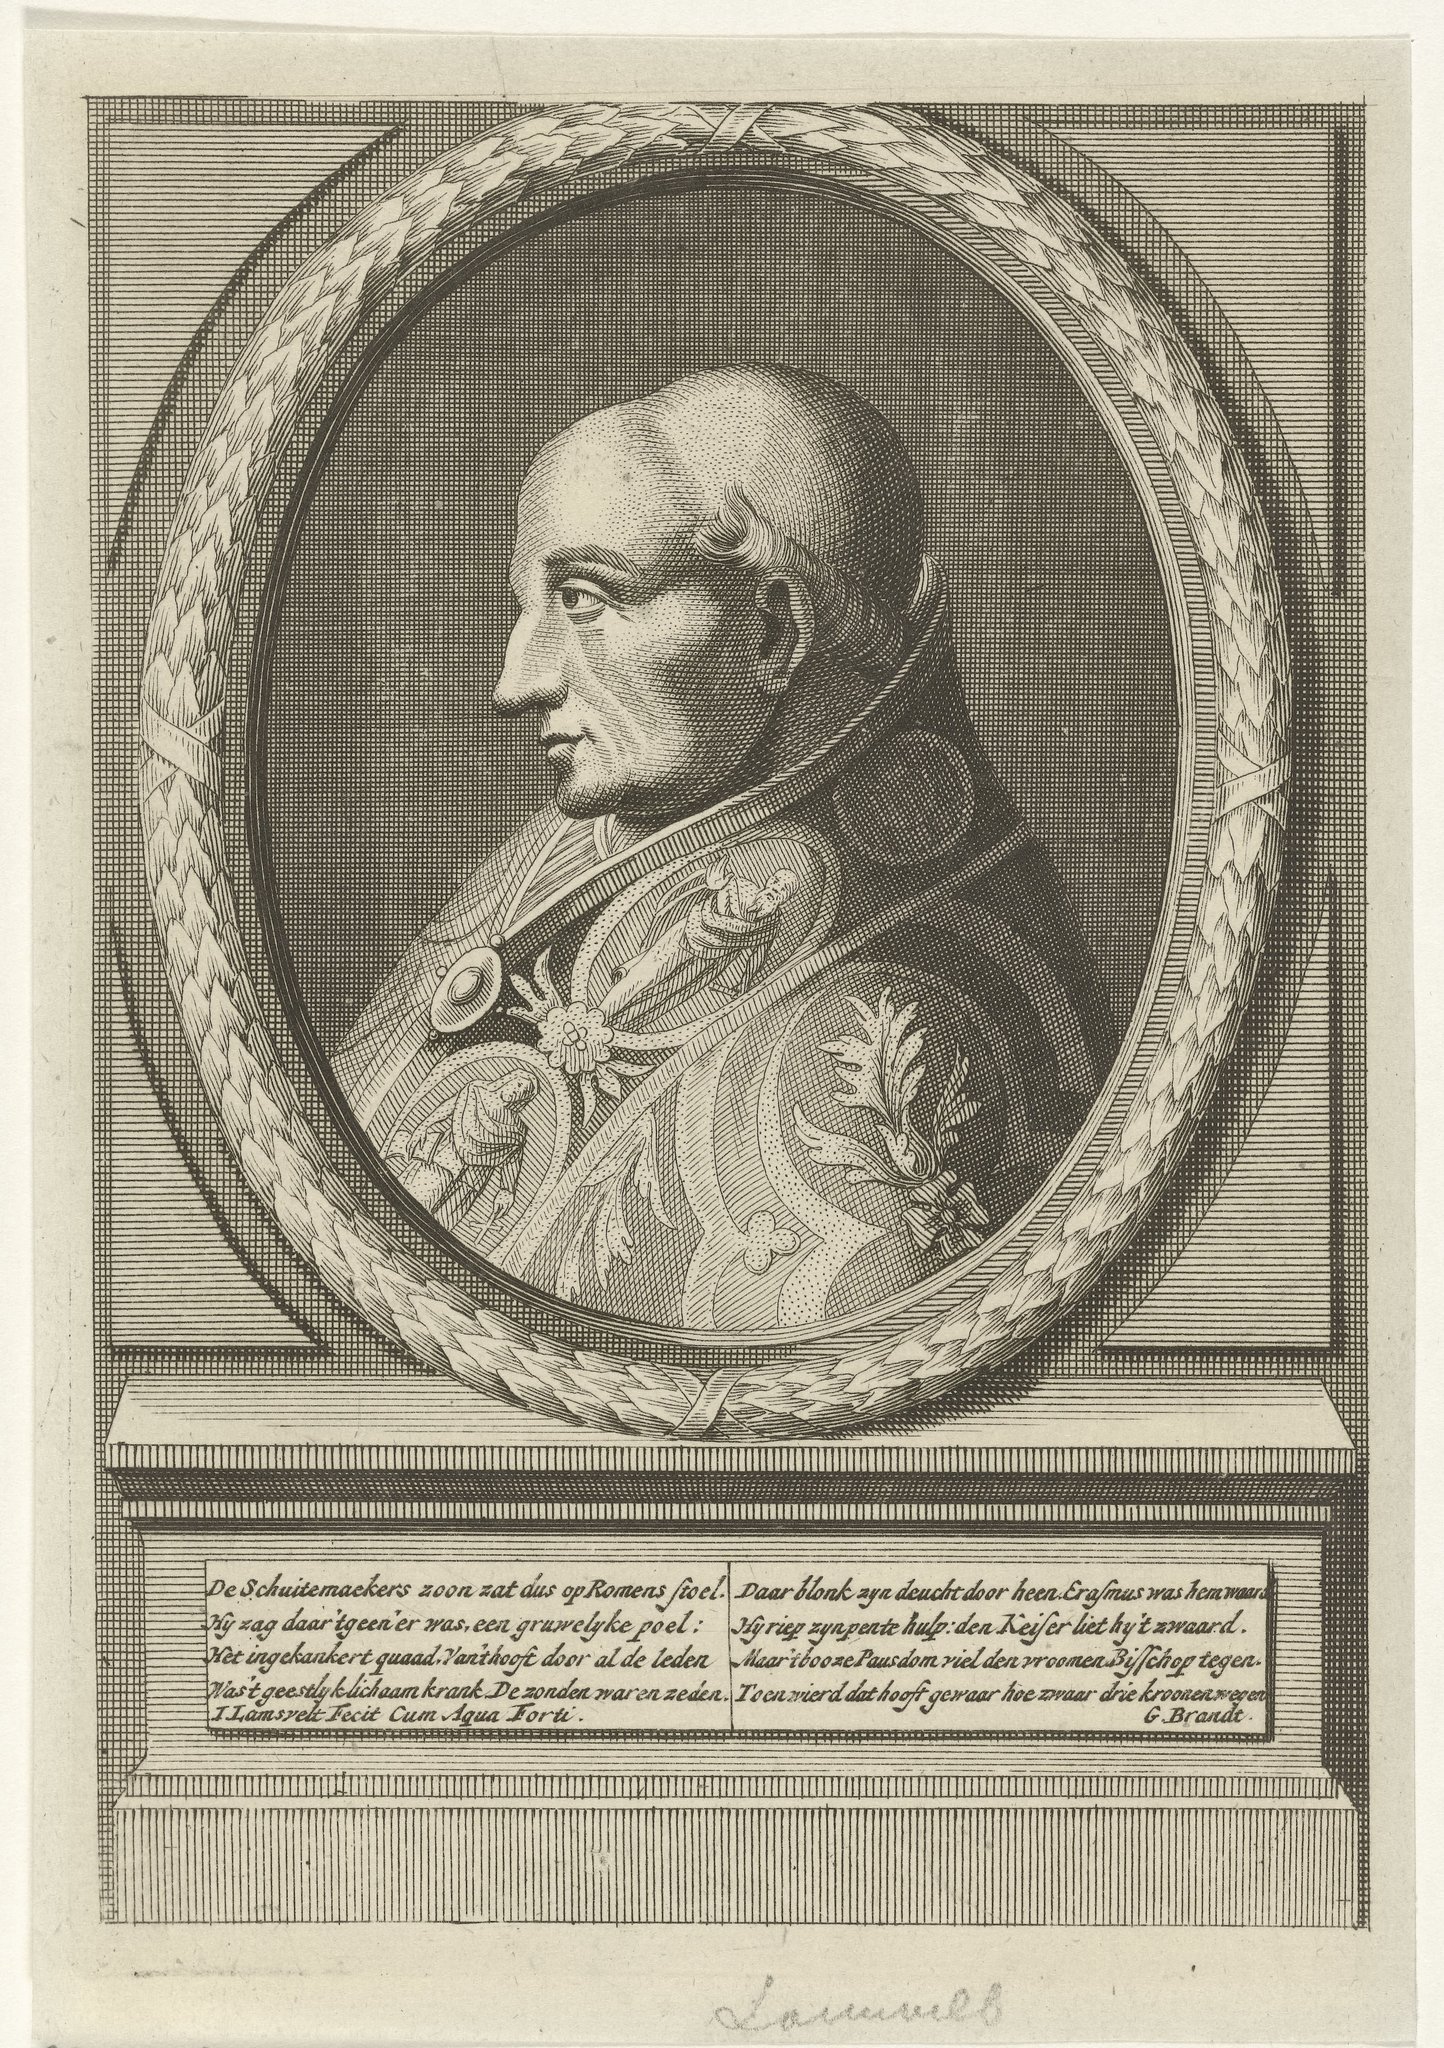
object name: print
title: Portret van paus Adrianus VI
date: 1696-1743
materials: paper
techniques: engraving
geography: amsterdam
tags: utrecht, rome, clergyman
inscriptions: collector's mark: Lugt 2228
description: Prent ook gebruikt in: G. Brandts Historie der Reformatie, en andre kerkelyke geschiedenissen, in en ontrent de Nederlanden. Met eenige aantekeningen en aenmerkingen, Naerder oversien, merkelijk vermeerdert, en vervolgt tot het jaer 1600 [Het eerste deel]. 2e druk [moet een latere druk zijn]. Amsterdam: Jan Rieuwertsz. en Hendrik en Dirk Boom [?], 1677 [in of na 1696], tussen p. 84 en 85.* *Hoewel op de titelpagina deze uitgevers worden genoemd en het jaartal 1677 staat vermeld als jaar van uitgave, kan dit niet kloppen. Deze uitgave heeft weliswaar tevens exact dezelfde titel als de werkelijke tweede druk uit 1677, maar is typografisch anders en bevat andere prenten. Alle prenten zijn van de hand van Jan Lamsvelt (werkzame periode: 1696-1743), waardoor het geheel in of na 1696 te dateren valt.